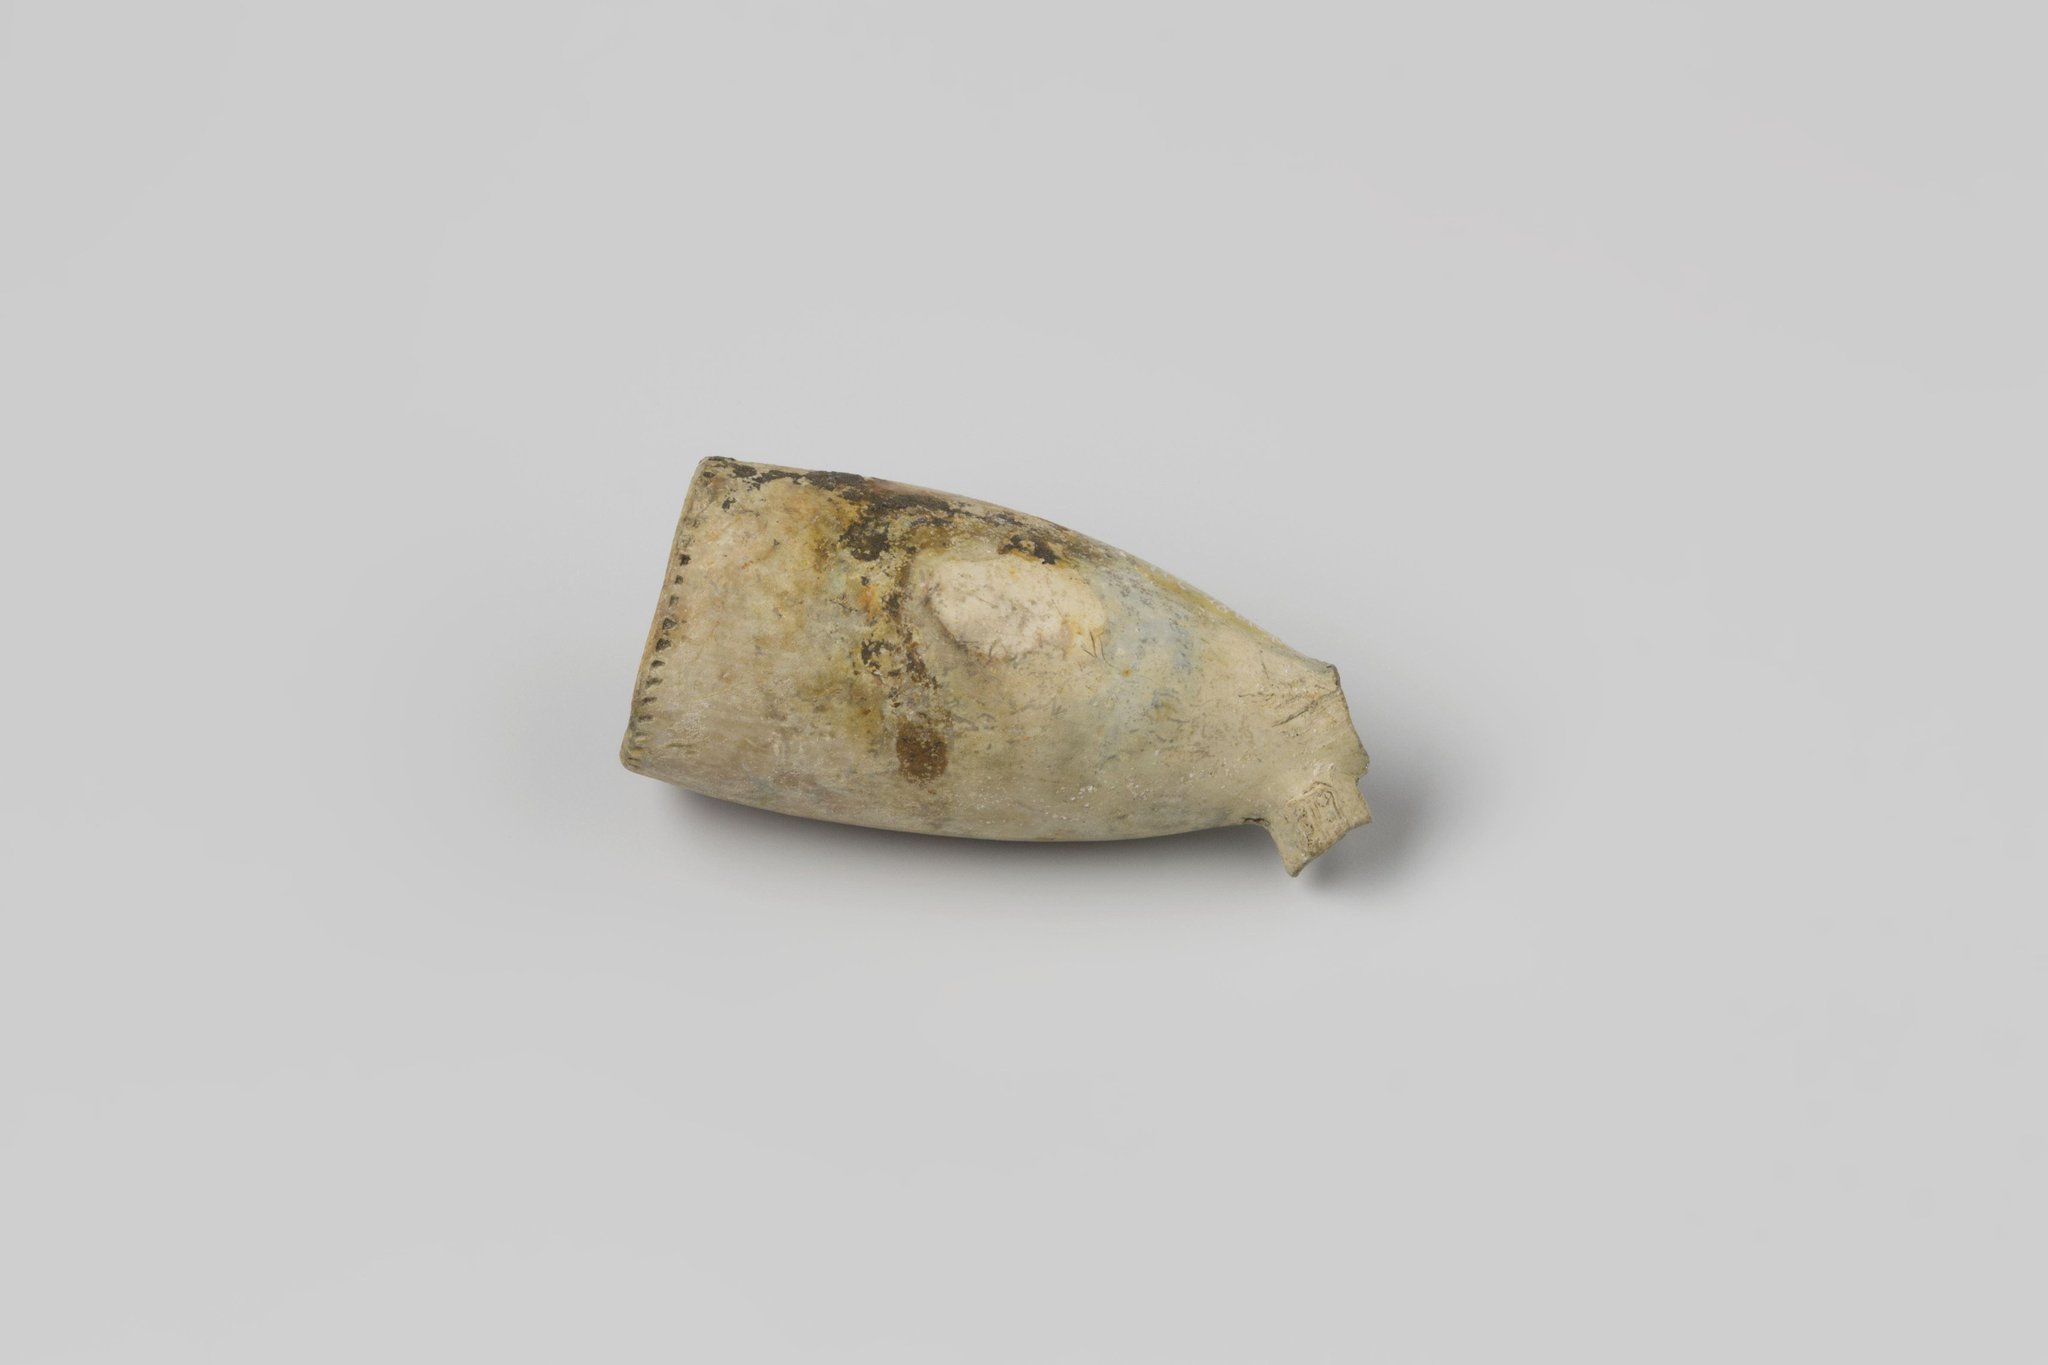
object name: pipe bowl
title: Pijpenkop uit het wrak van de Oost-Indiëvaarder Hollandia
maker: Anonymous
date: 1700-1743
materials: clay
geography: netherlands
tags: verenigde oostindische compagnie, hollandia (schip), annet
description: Pipe, bowl, heelmark illegible; fragment, no hsm.